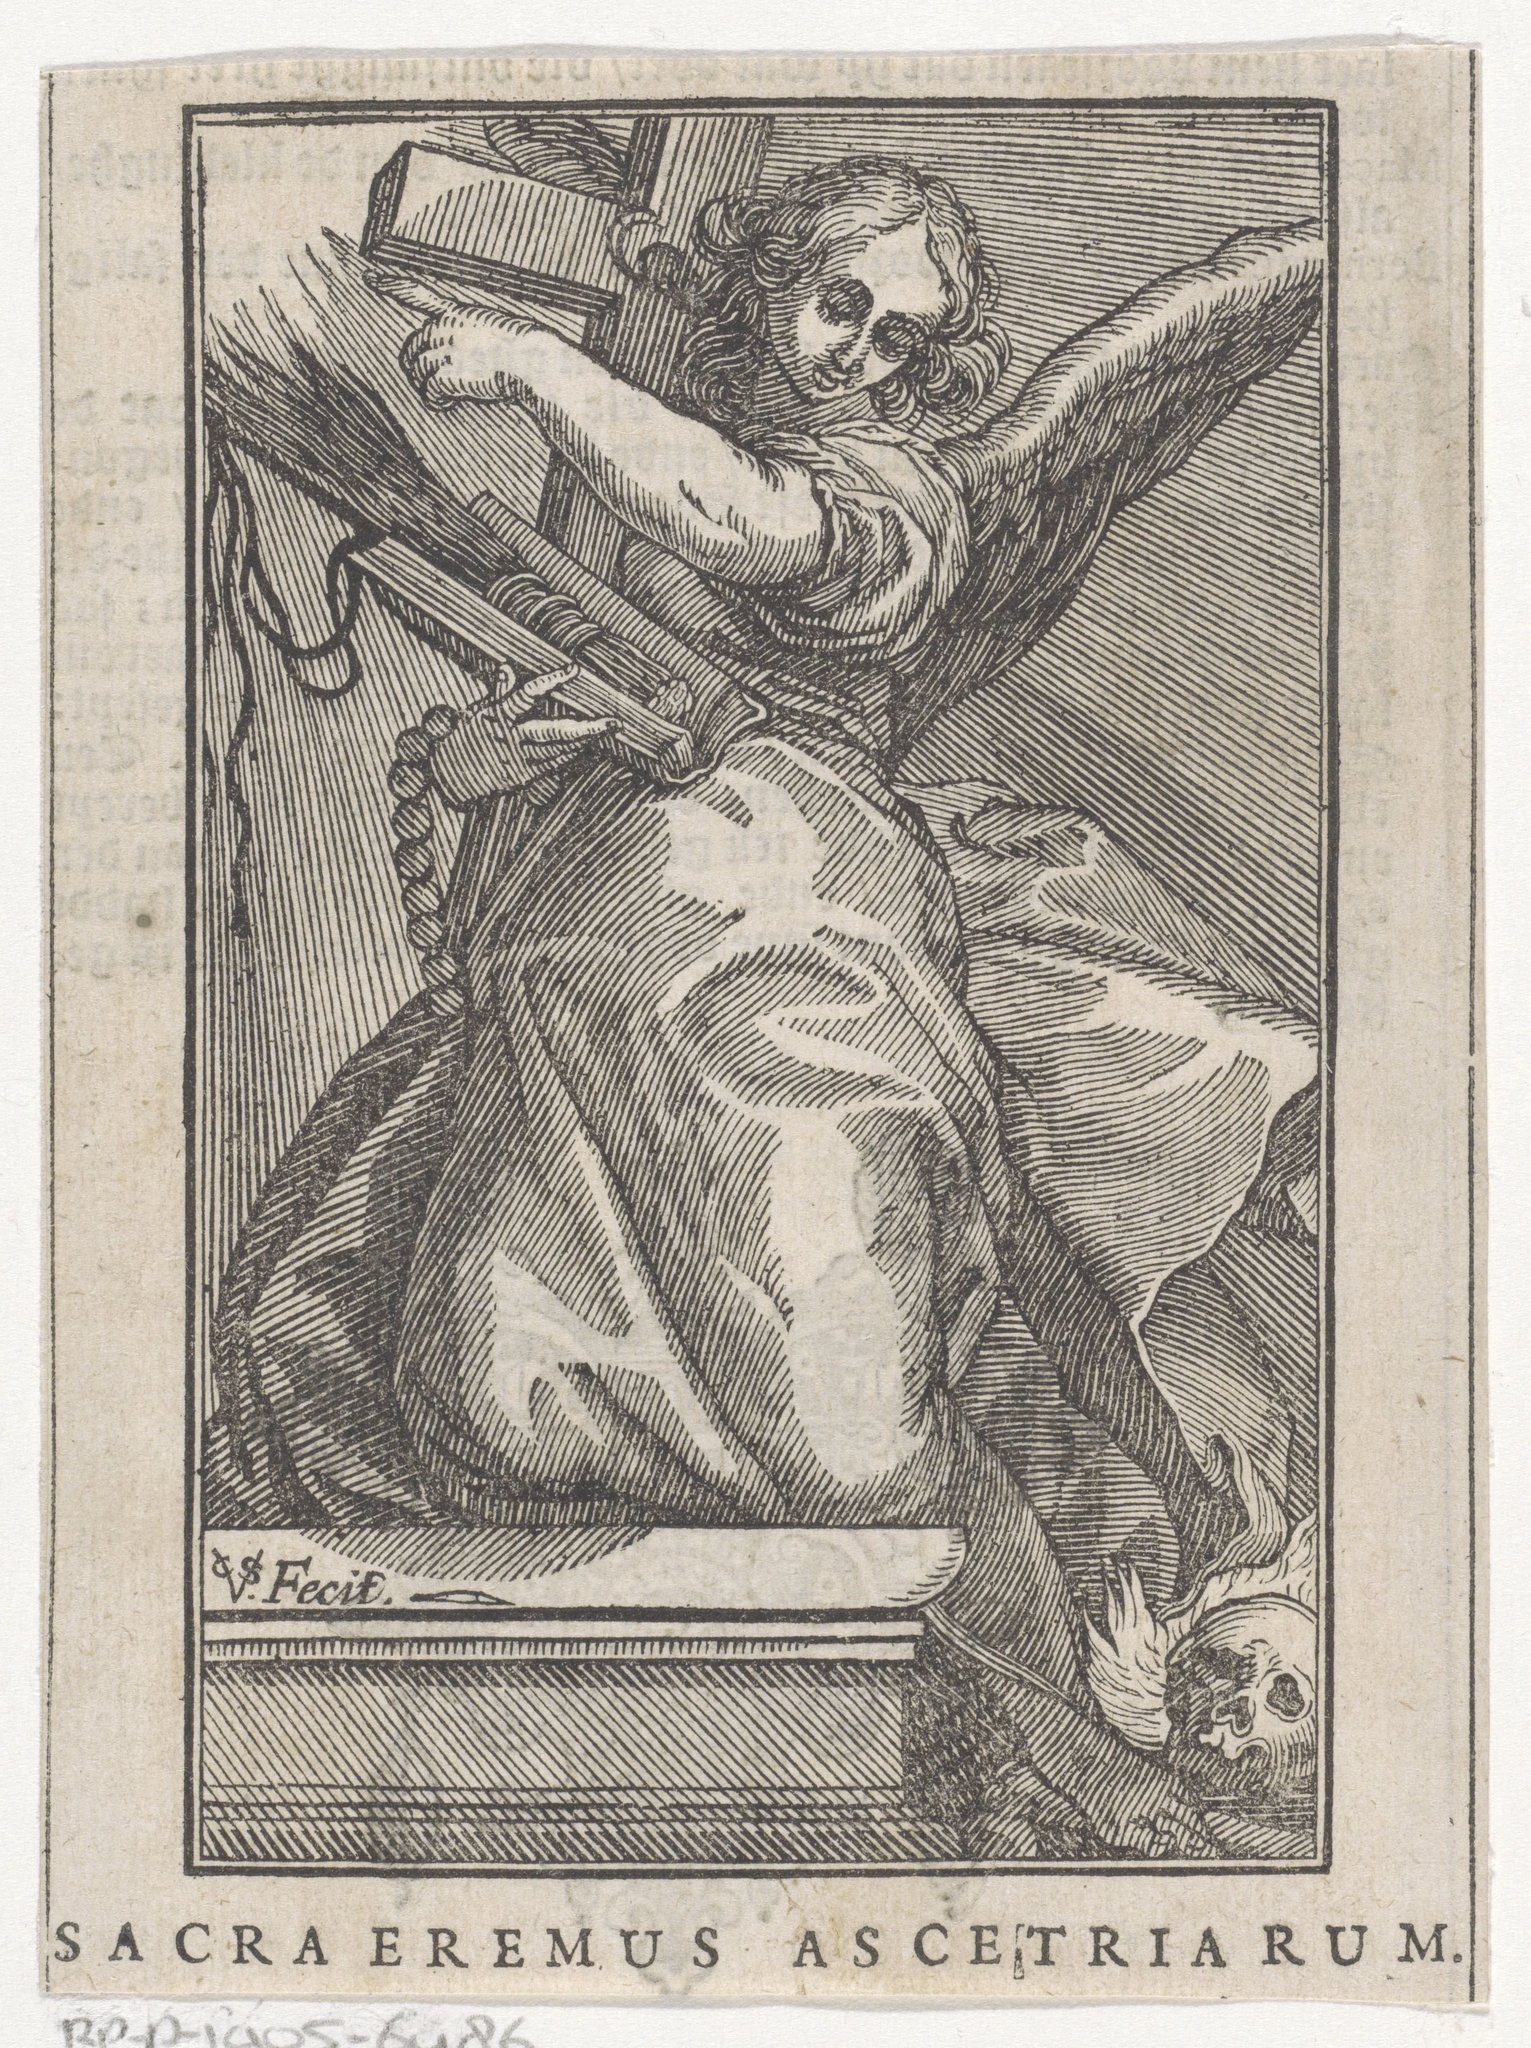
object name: print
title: Engel met attributen van kluizenaar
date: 1644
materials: paper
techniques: letterpress printing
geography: amsterdam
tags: anchorite, hermit, angels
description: Engel met attributen die een kluizenaar of kluizenares nodig heeft voor het leiden van een ascetisch leven zoals een kruis, rozenkrans, bijbel en zweep.